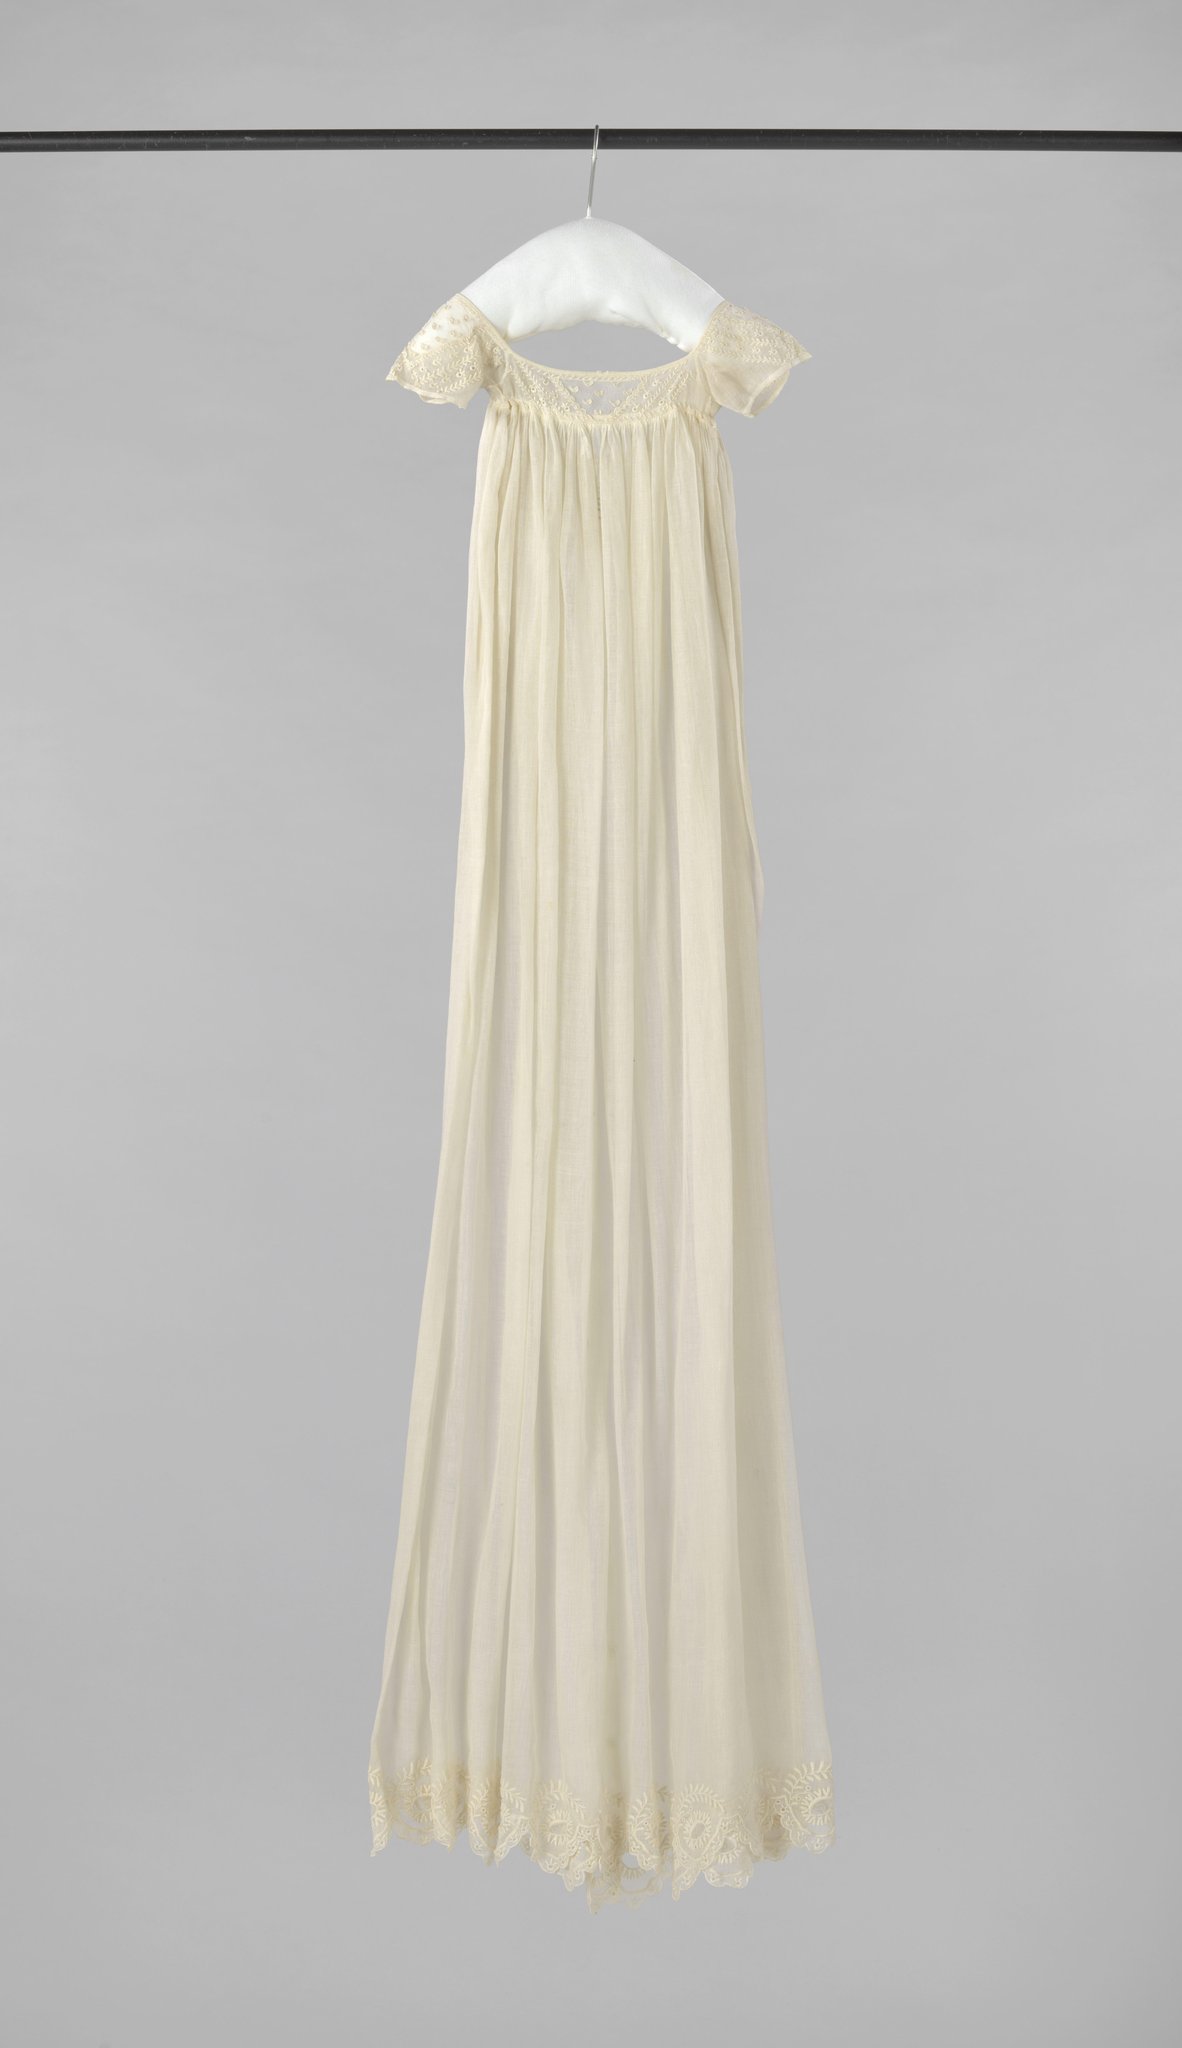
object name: doopjurk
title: Doopjurk van batist met een onderrok van witte zijde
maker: Anonymous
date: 1790-1815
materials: textile, silk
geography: europe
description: Een batisten doopjurk met een wit zijden onderrok.